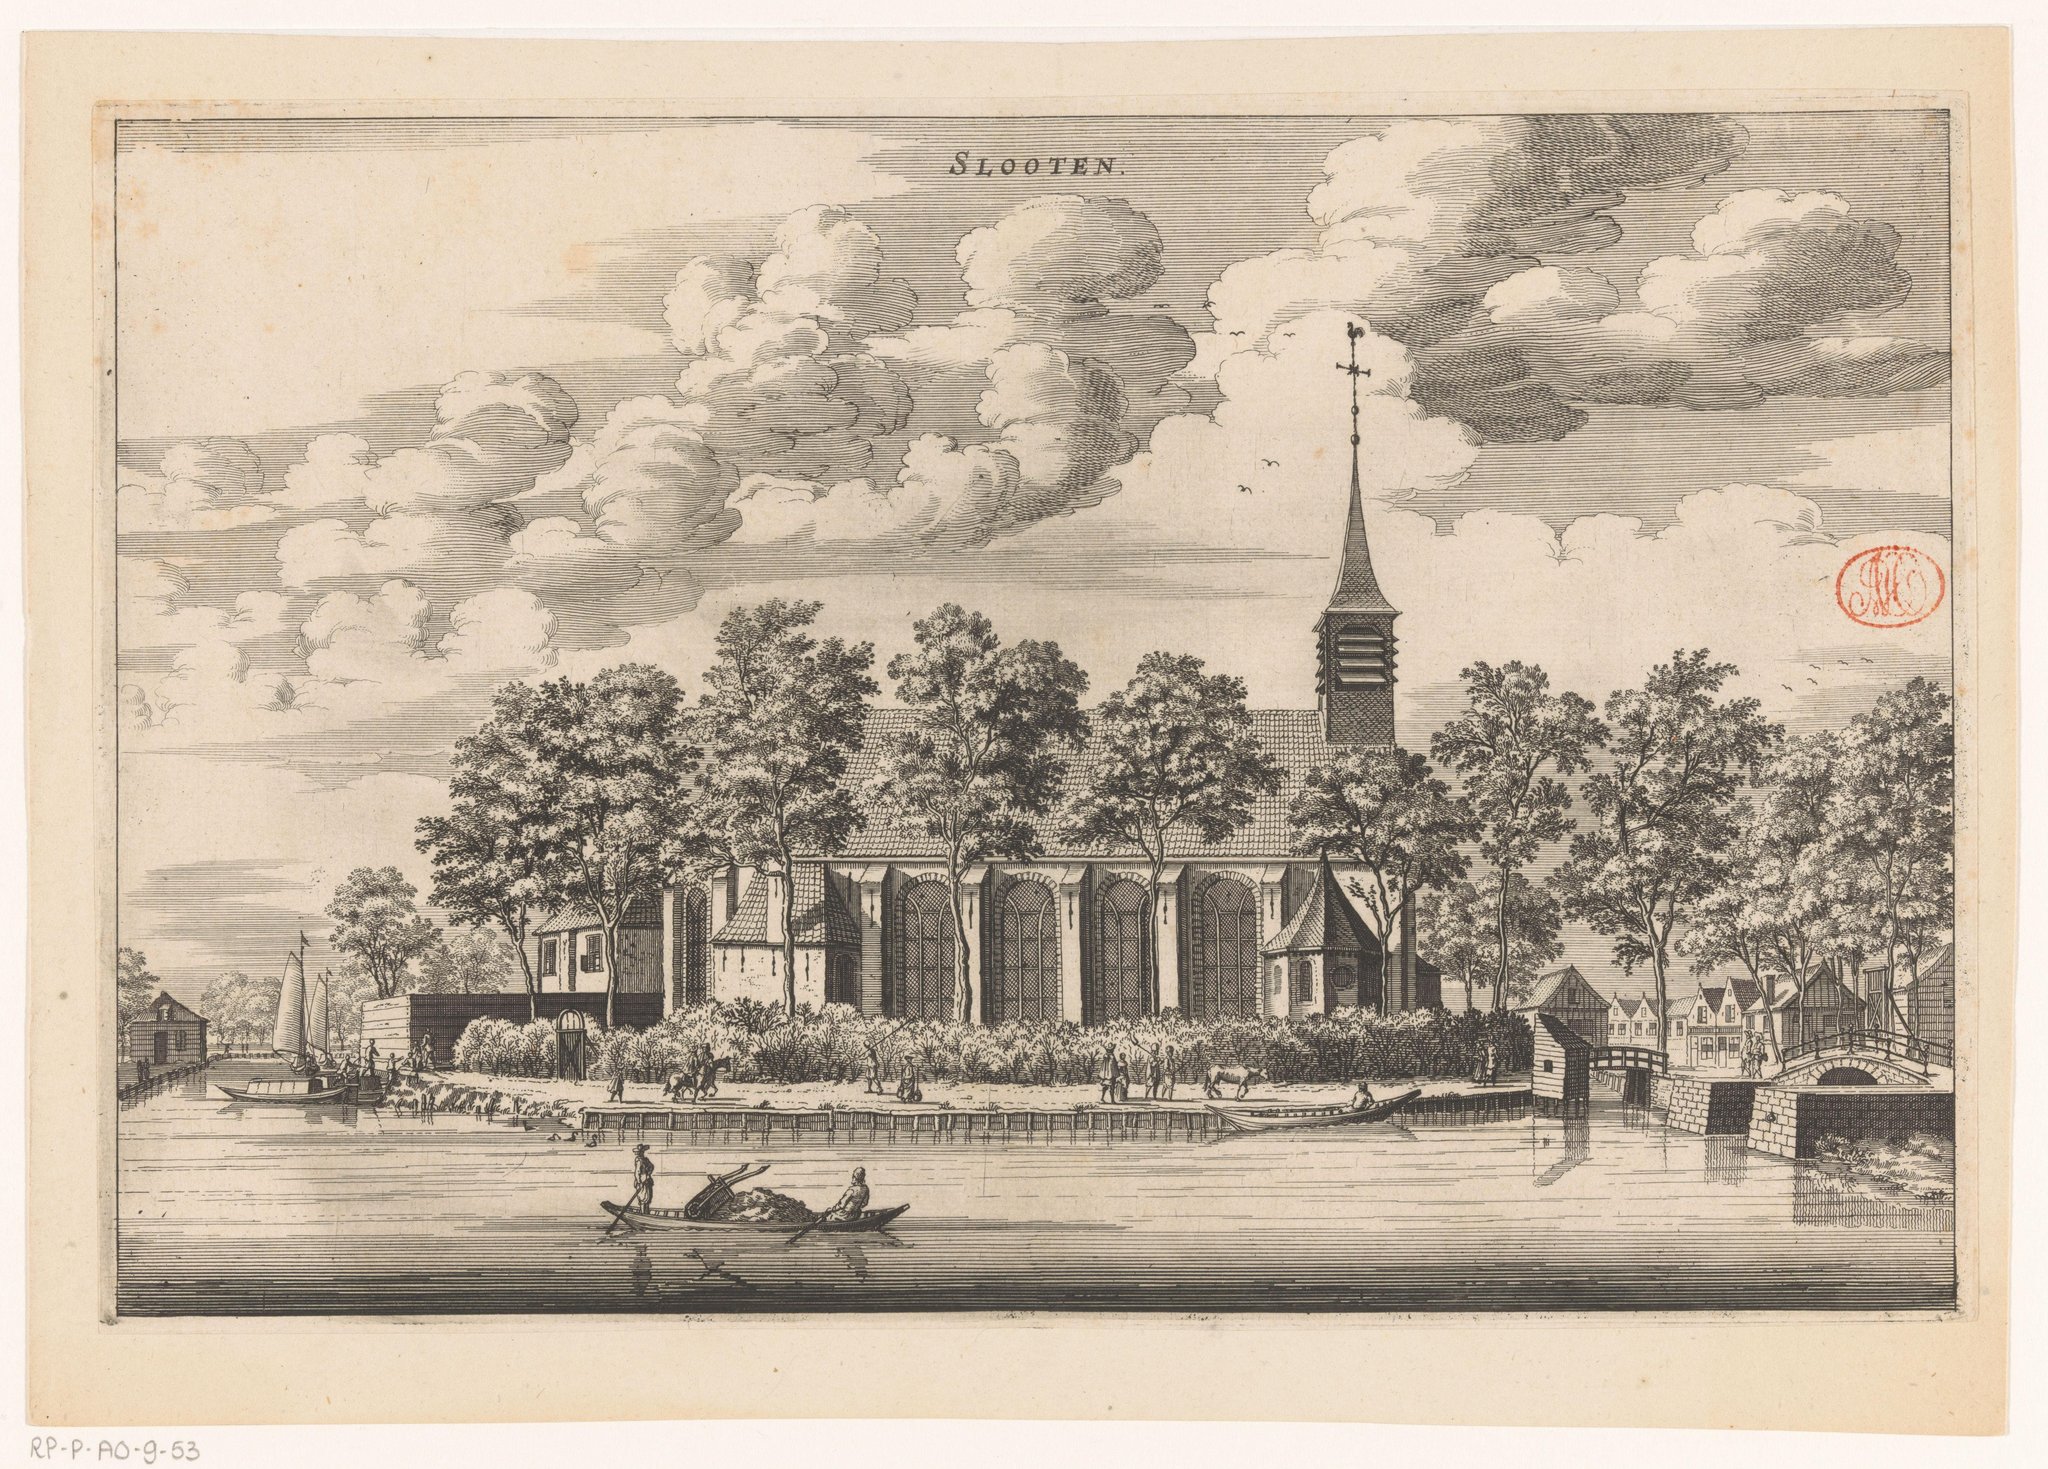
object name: book illustration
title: Slooten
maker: jacob van meurs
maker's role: draughtsman, print maker, publisher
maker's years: 1619-1680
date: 1663-1664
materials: paper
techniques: etching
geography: amsterdam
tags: sailing-ship, sailing-boat, church (exterior), rowing-boat, canoe, etc., bridge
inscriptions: collector's mark: Lugt 195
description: Prent ook gebruikt in: Dapper, Olfert. Historische beschryving der stadt Amsterdam: waer in de voornaemste geschiedenissen (na een kort verhael van gansch Hollant en d'omleggende dorpen (…). Amsterdam: Jacob van Meurs, 1663, tussen p. 36 en 36. En in: Zesen, Philipp von. Beschreibung der Stadt Amsterdam: darinnen von derselben ersten Ursprunge bis auf gegenwärtigen Zustand (…). Amsterdam: Joachim Nosche, 1664, tussen p. 138 en 139.